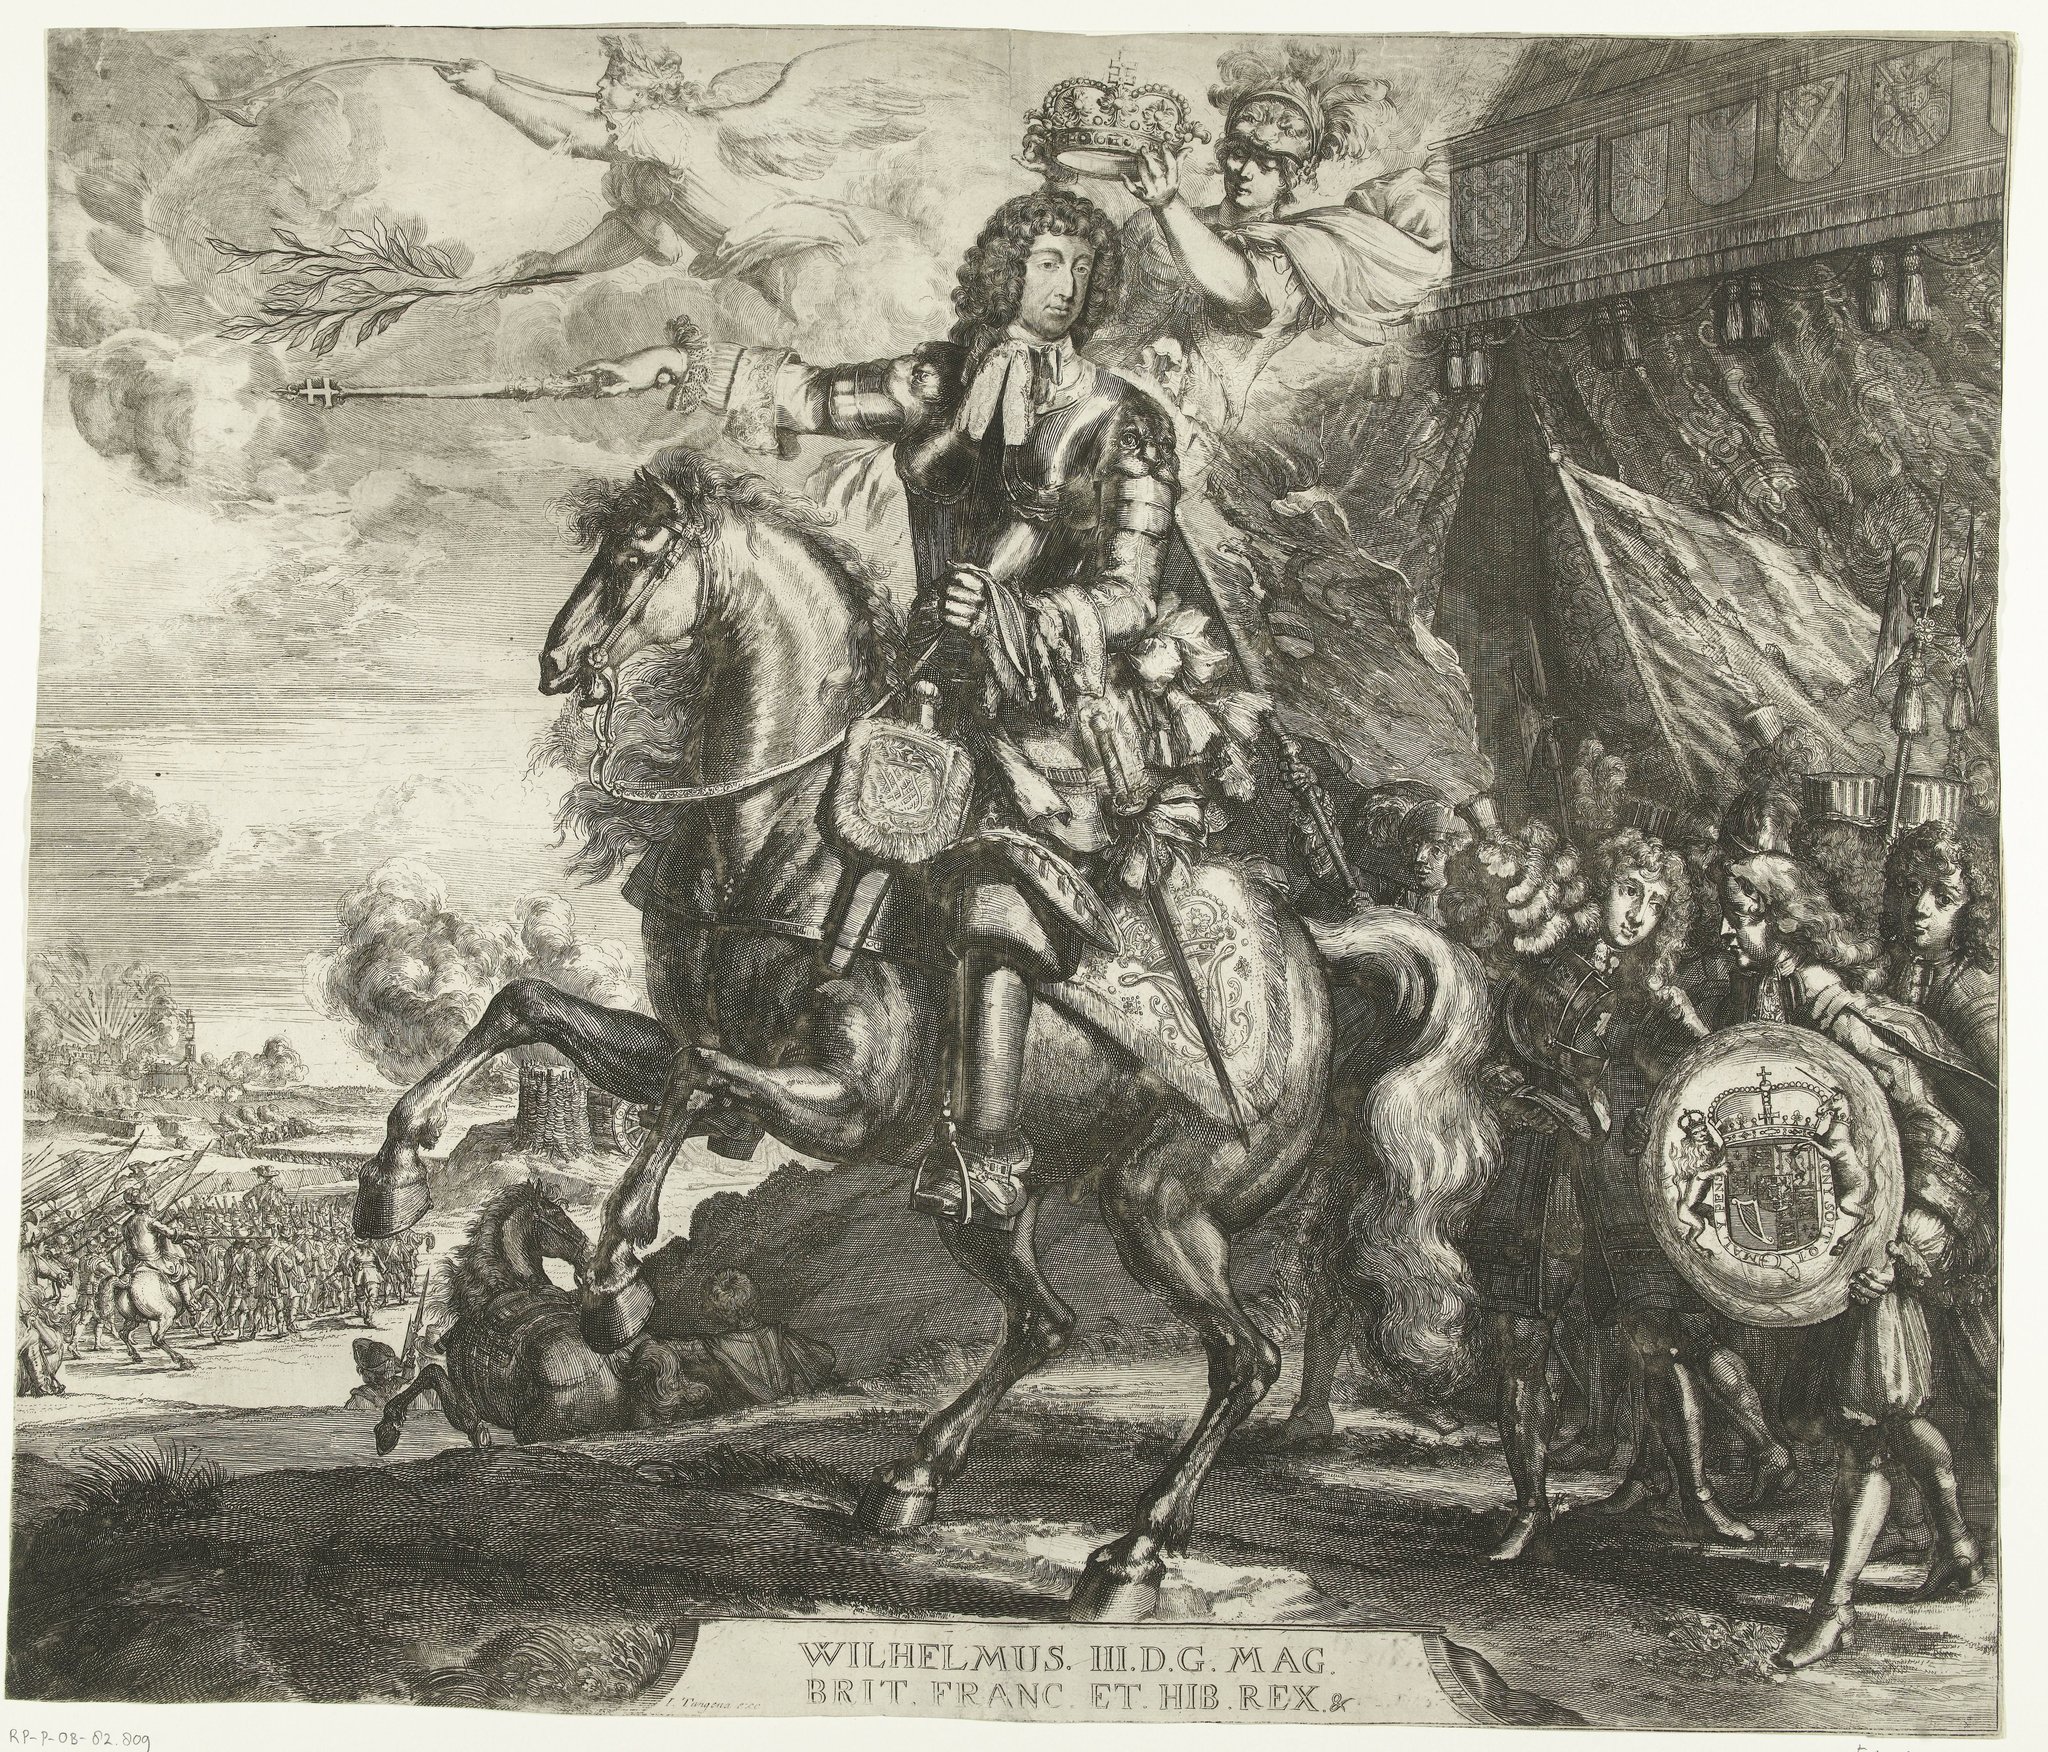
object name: print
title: Ruiterportret van Willem III, prins van Oranje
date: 1689-1691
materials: paper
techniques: engraving, etching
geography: northern netherlands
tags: the hague, william iii (prince of orange and king of england, scotland, and ireland), fame; 'fama', 'fama buona', 'fama chiara' (ripa) (+ abstract concept represented by female figure)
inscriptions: collector's mark: Lugt 2228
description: Ruiterportret van Willem III. Bellona of Brittannia houdt de Engelse kroon boven zijn hoofd. In de wolken blaast Faam op een bazuin. Rechts een legertent met een aantal figuren en zijn wapen met een kroon, gedecoreerd met de Kousenband en het devies van de Orde van de Kousenband. Op de achtergrond de beschieting van een stad, oorlogstafereel uit de strijd in Ierland. In een kader zijn naam en titels.